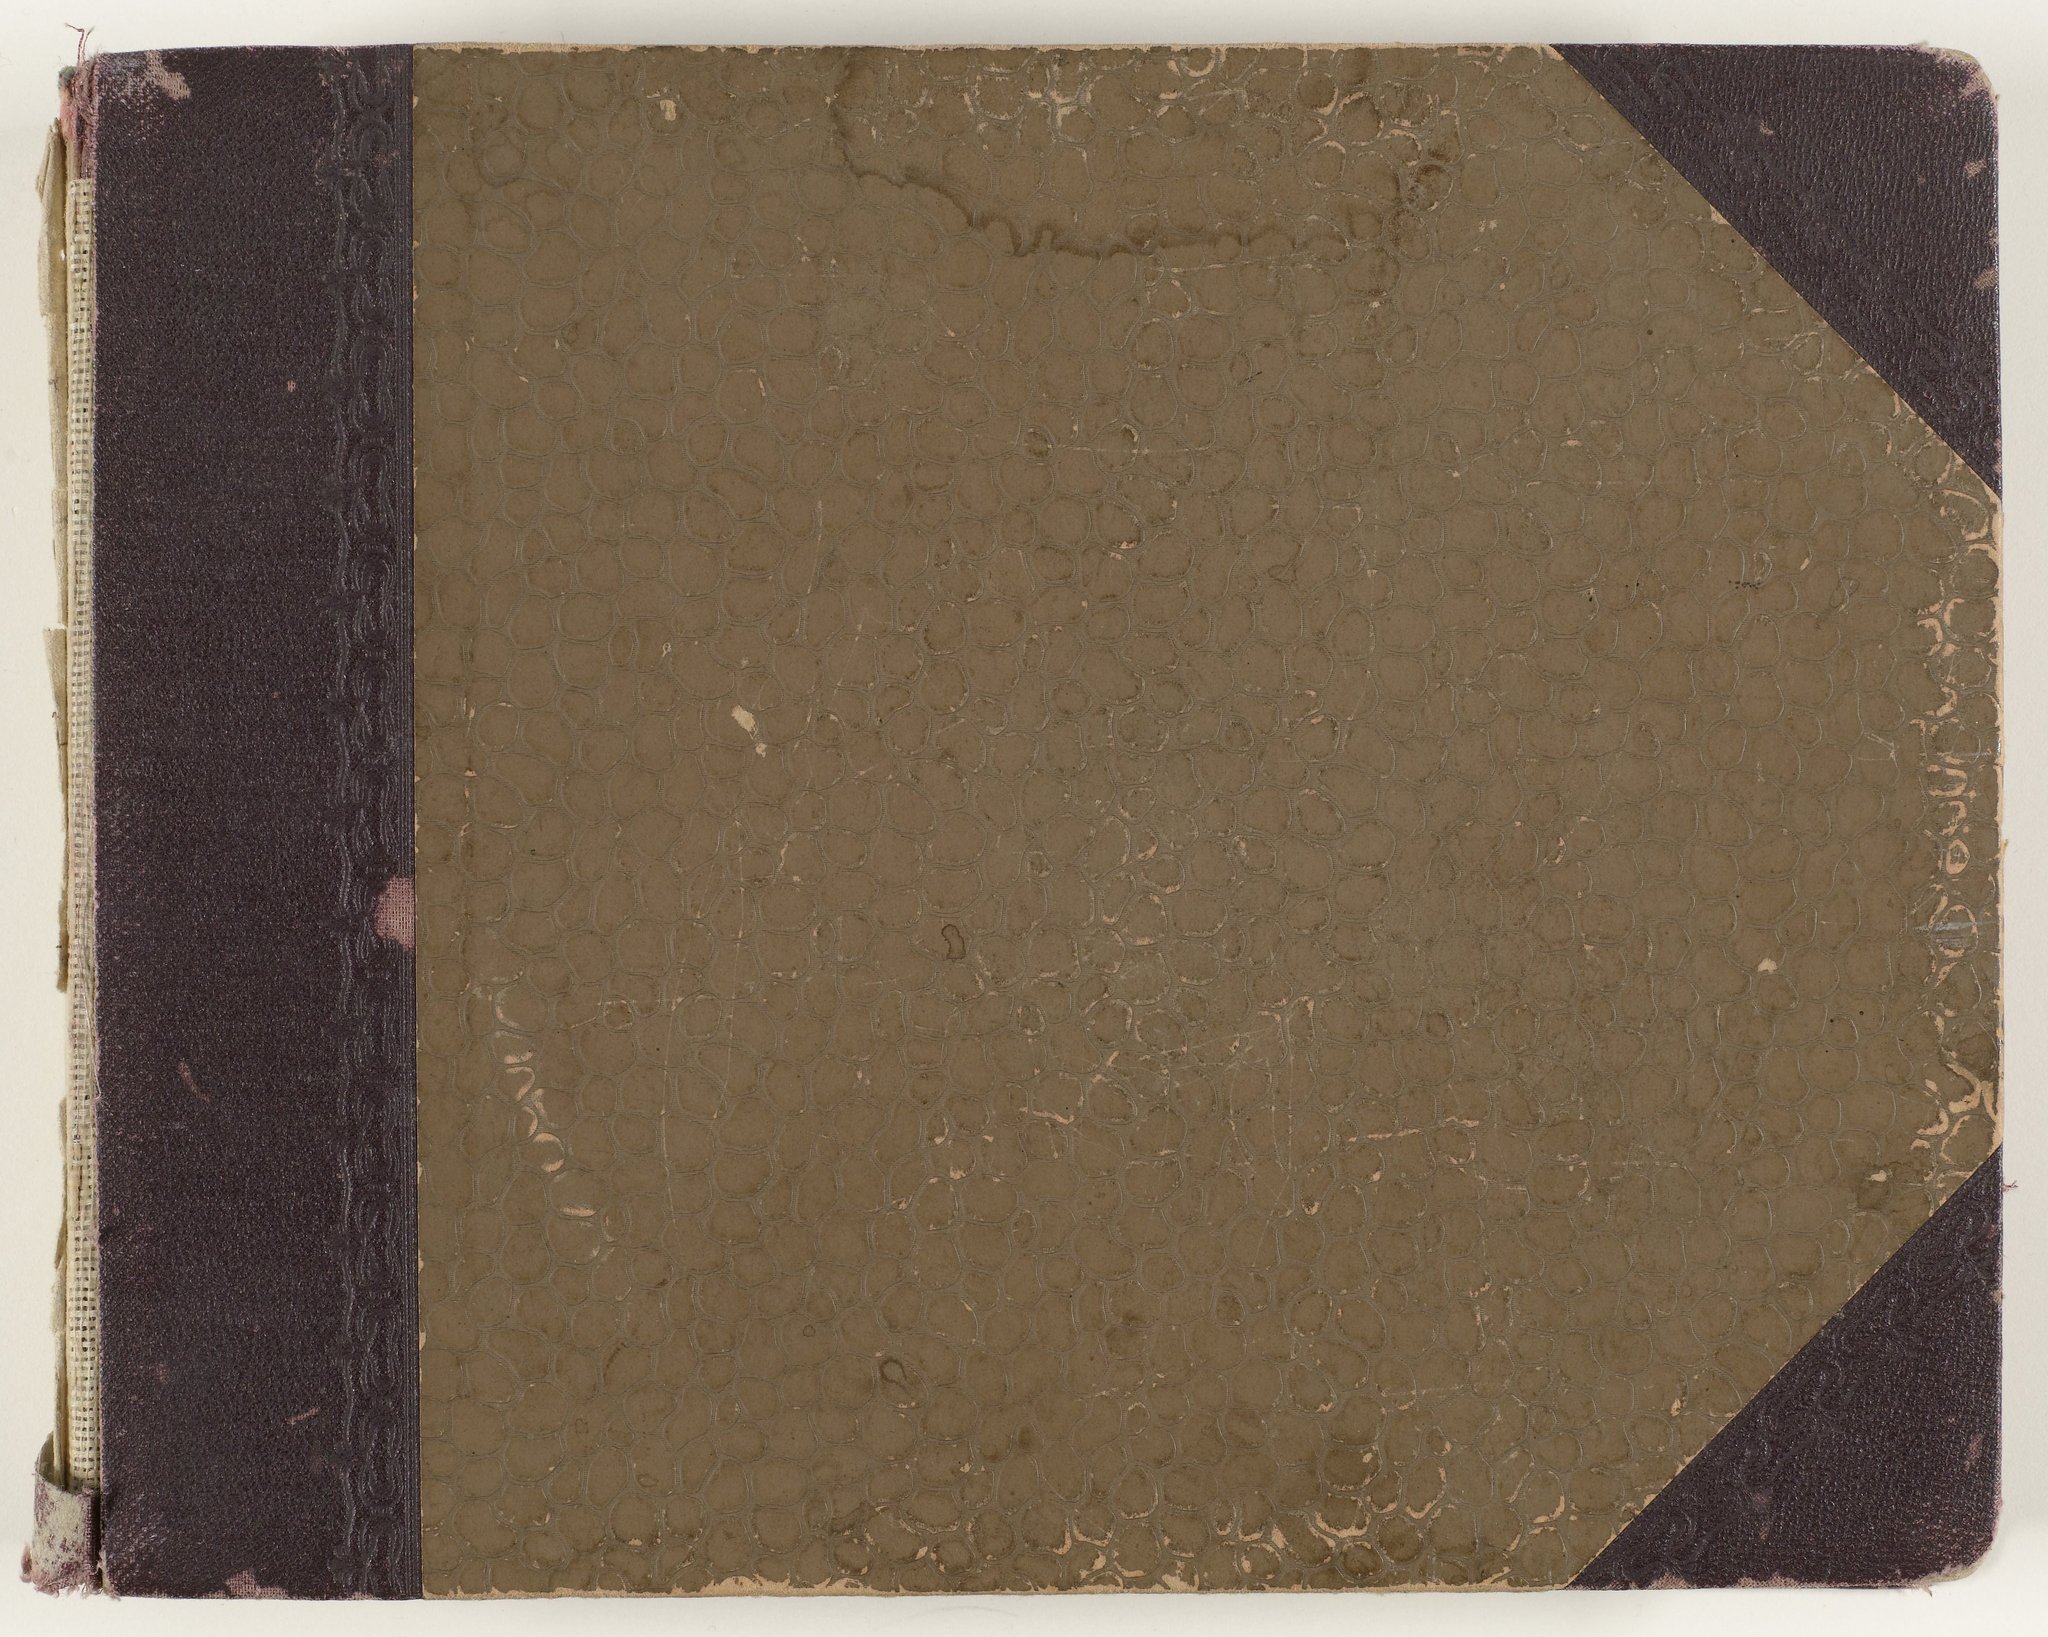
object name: photograph album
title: Aanleg van de Lawaspoorweg in Suriname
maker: jacob evert wesenhagen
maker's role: amateurfotograaf, arts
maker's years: 1862-1924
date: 1903-1912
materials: cardboard, leather, linen, photographic support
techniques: photography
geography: suriname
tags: jacob evert wesenhagen, suriname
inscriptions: annotation: ‘Samengesteld door: Jacob Evert Wesenhagen, arts / geb. 2 nov 1862 te Paramaribo / t 2 nov 1924 te Paramaribo / gehuwd te Pramaribo 27 apr 1892 met Marie Anna Paulina Duttenhofer / geb. 25 nov 1872 Disttrict Marowijne / t 4 jul 1899 Coronie (Sur.)’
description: Fotoalbum over de aanleg van de Lawaspoorweg in Suriname. Album in omslag van bruin imitatieleer. Schutblad met tekst: 'Samengesteld door: Jacob Evert Wesenhagen, arts etc.'. Binnenwerk bestaat uit 28 bladen en 60 foto's uit de periode 1903-1912. Wesenhagen werkte als geneesheer langs het traject van de spoorweg.